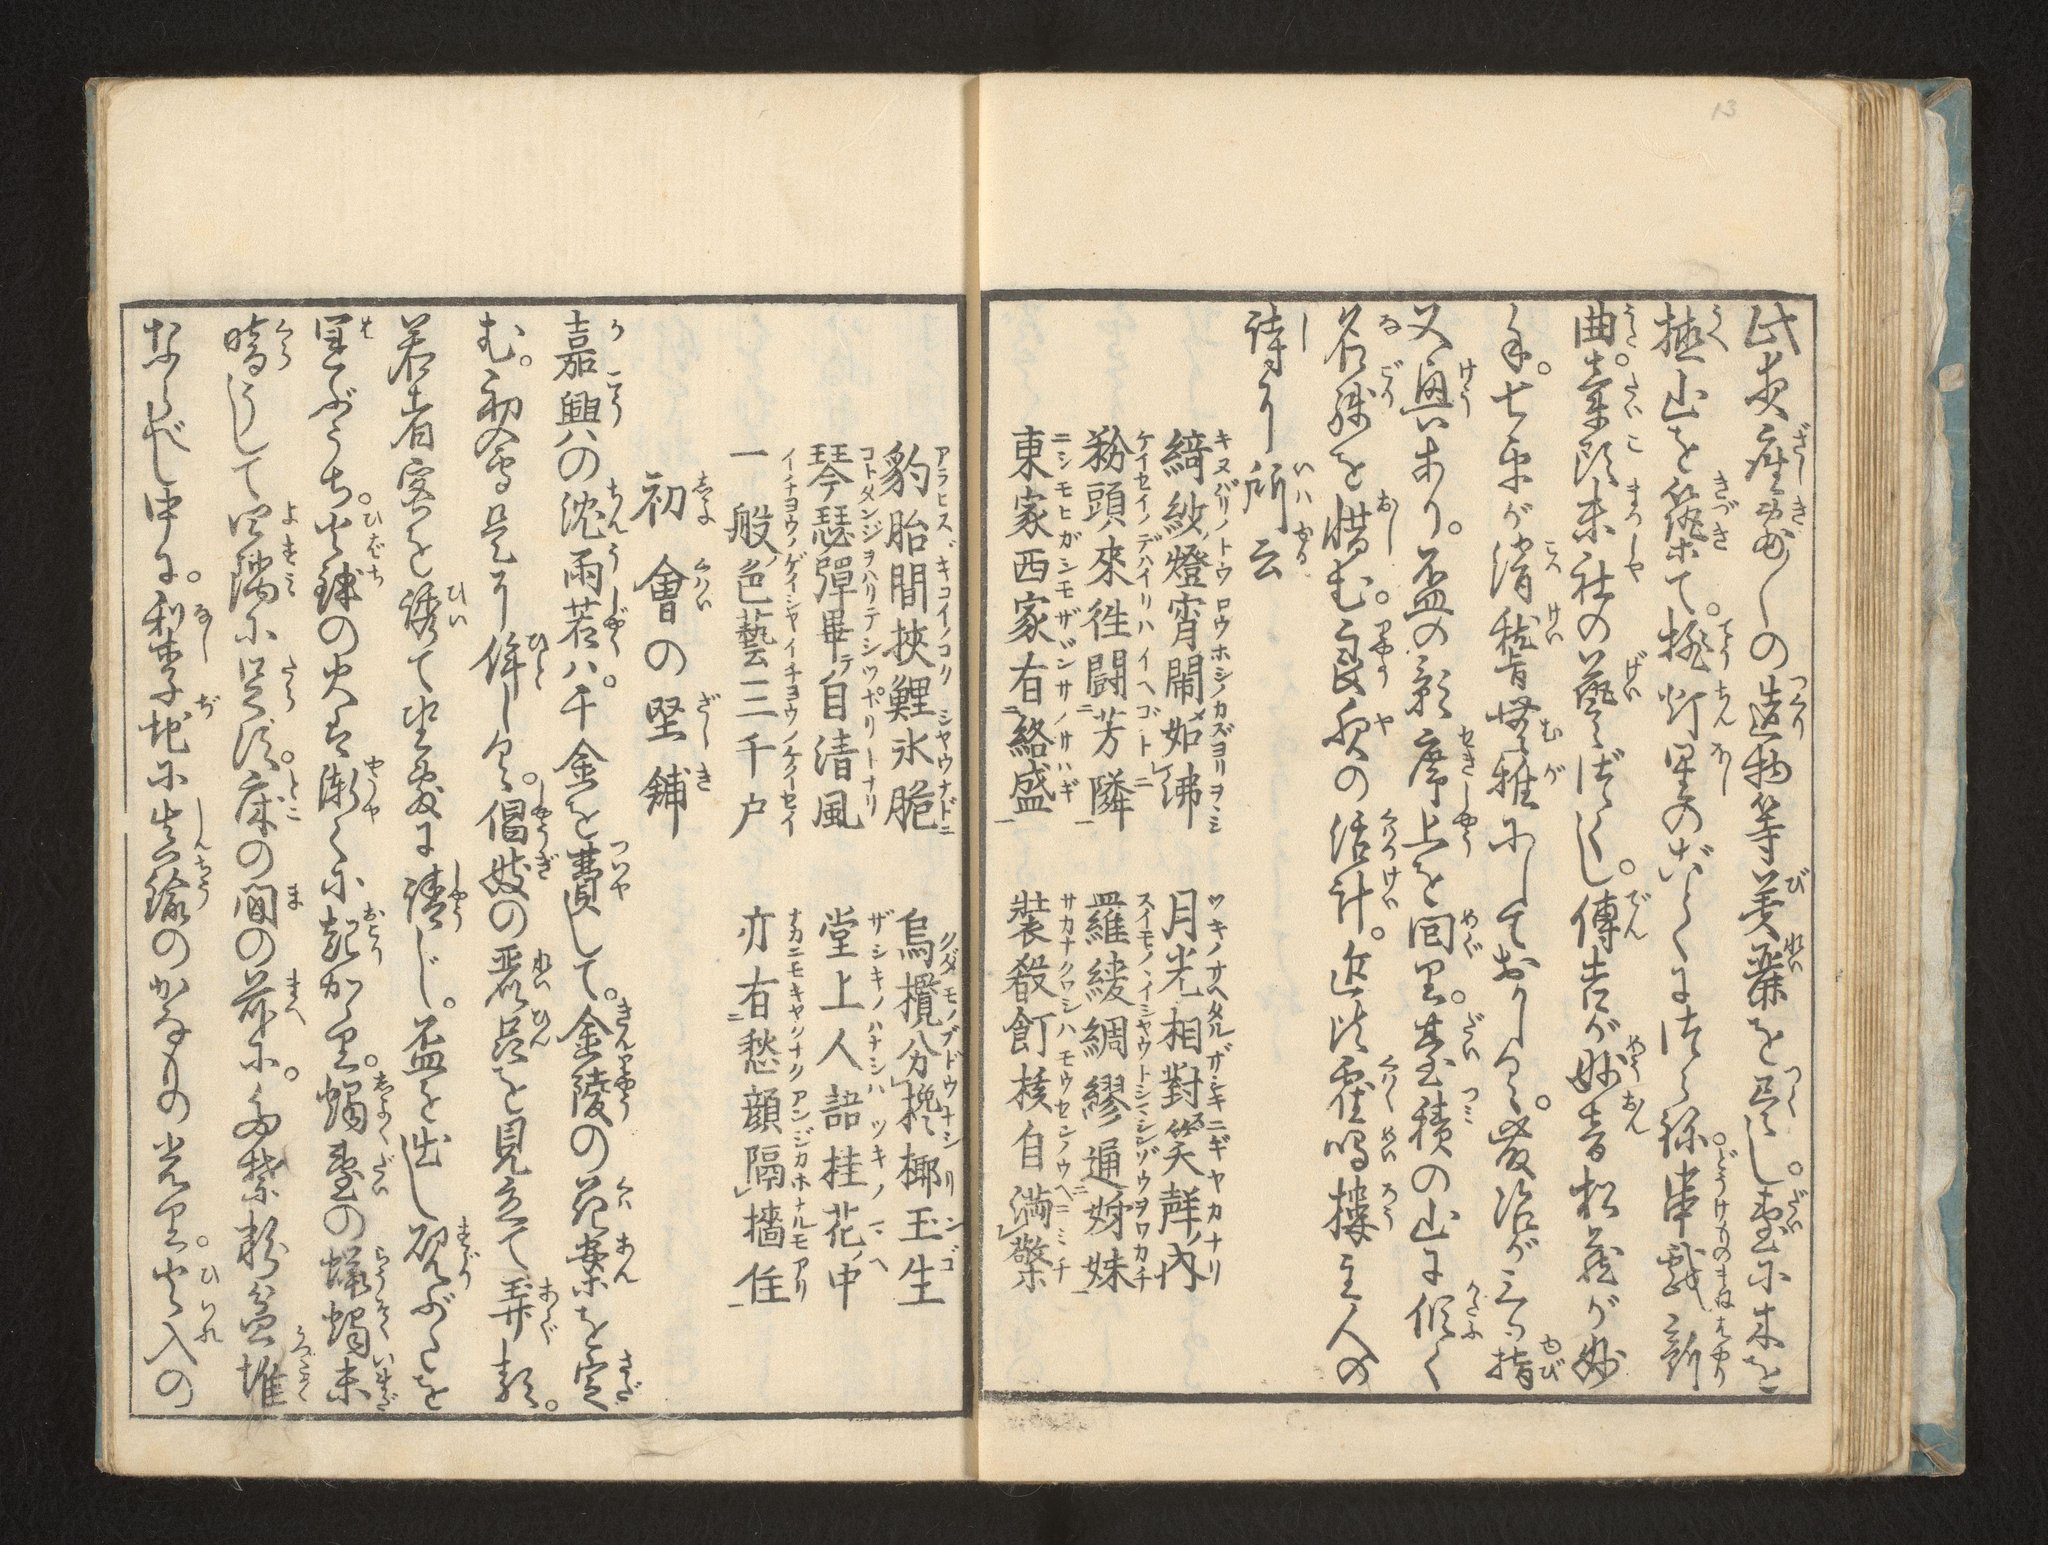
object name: page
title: Tekst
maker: jippensha ikku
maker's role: schrijver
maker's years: 1765-1831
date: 1804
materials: paper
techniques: woodcut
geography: edo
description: Vijfde en zesde tekstpagina van deel twee van Utamaro`s boek: Gebeurtenissen in de lusthuizen gedurende het jaar.